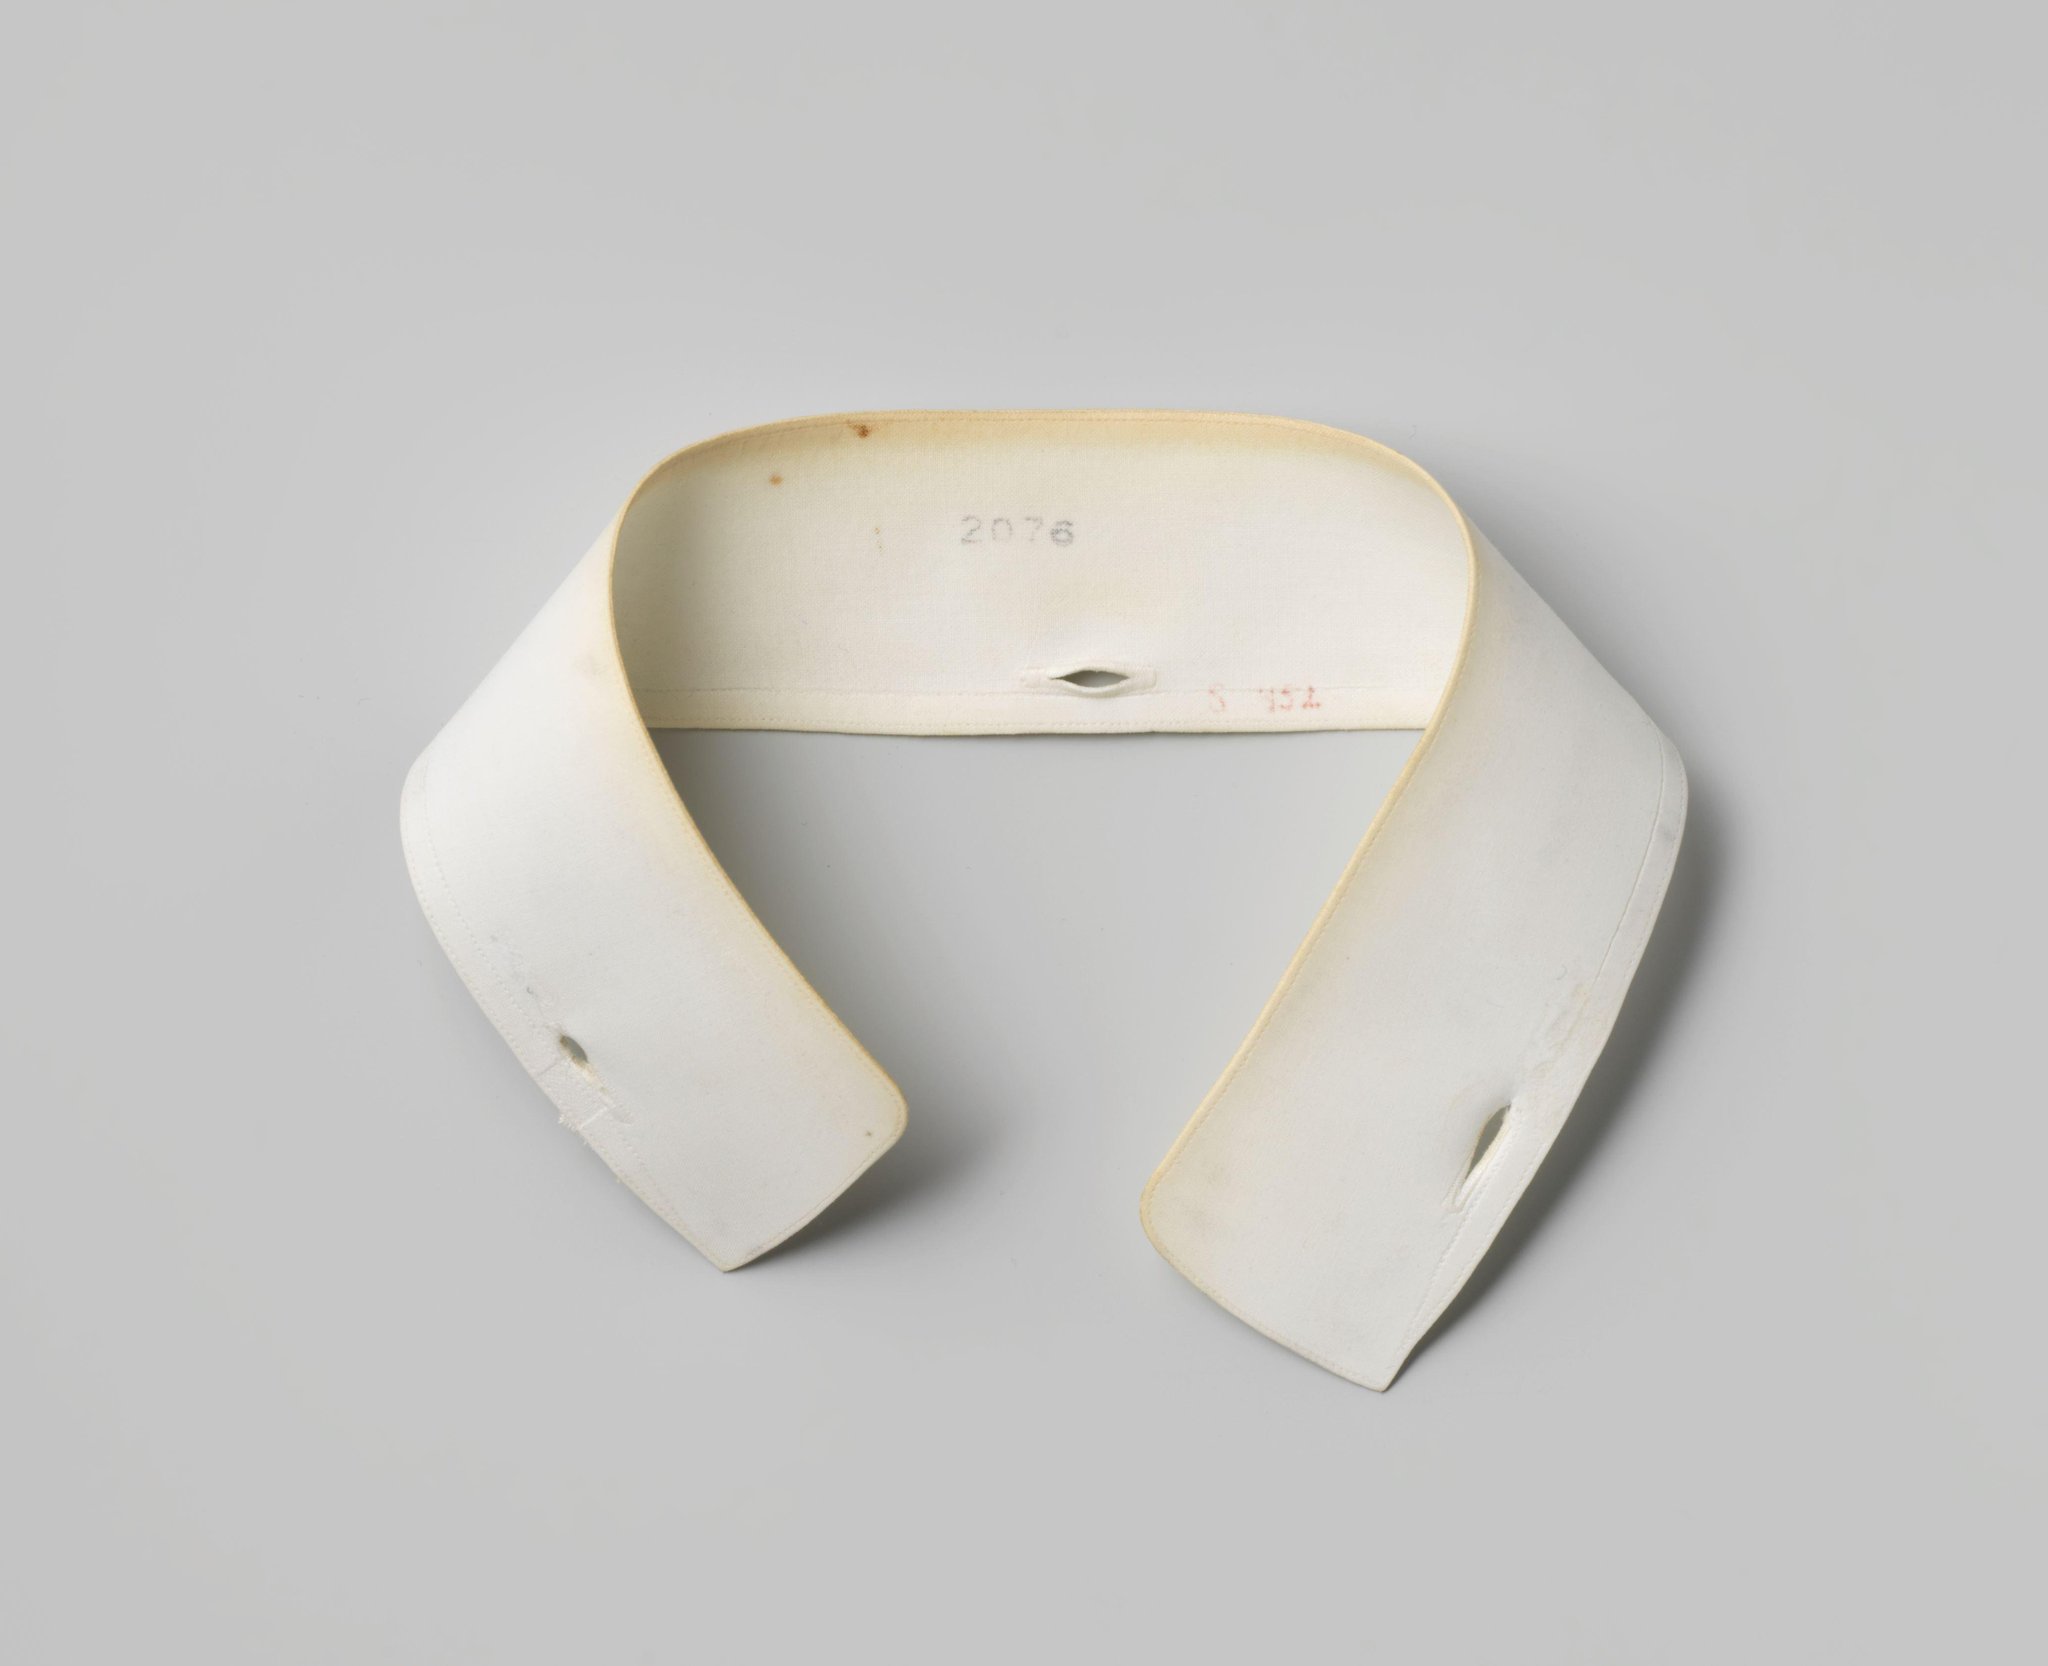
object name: band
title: Boord van ambtskostuum van burgemeester Hoytema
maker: Anonymous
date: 1800-1930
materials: textile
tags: mayor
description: Kostuum is gedragen door hem als burgemeester van Scherpenzeel en daarvoor door zijn vader als burgemeester van Bergambacht, Enkhuizen en Naarden.